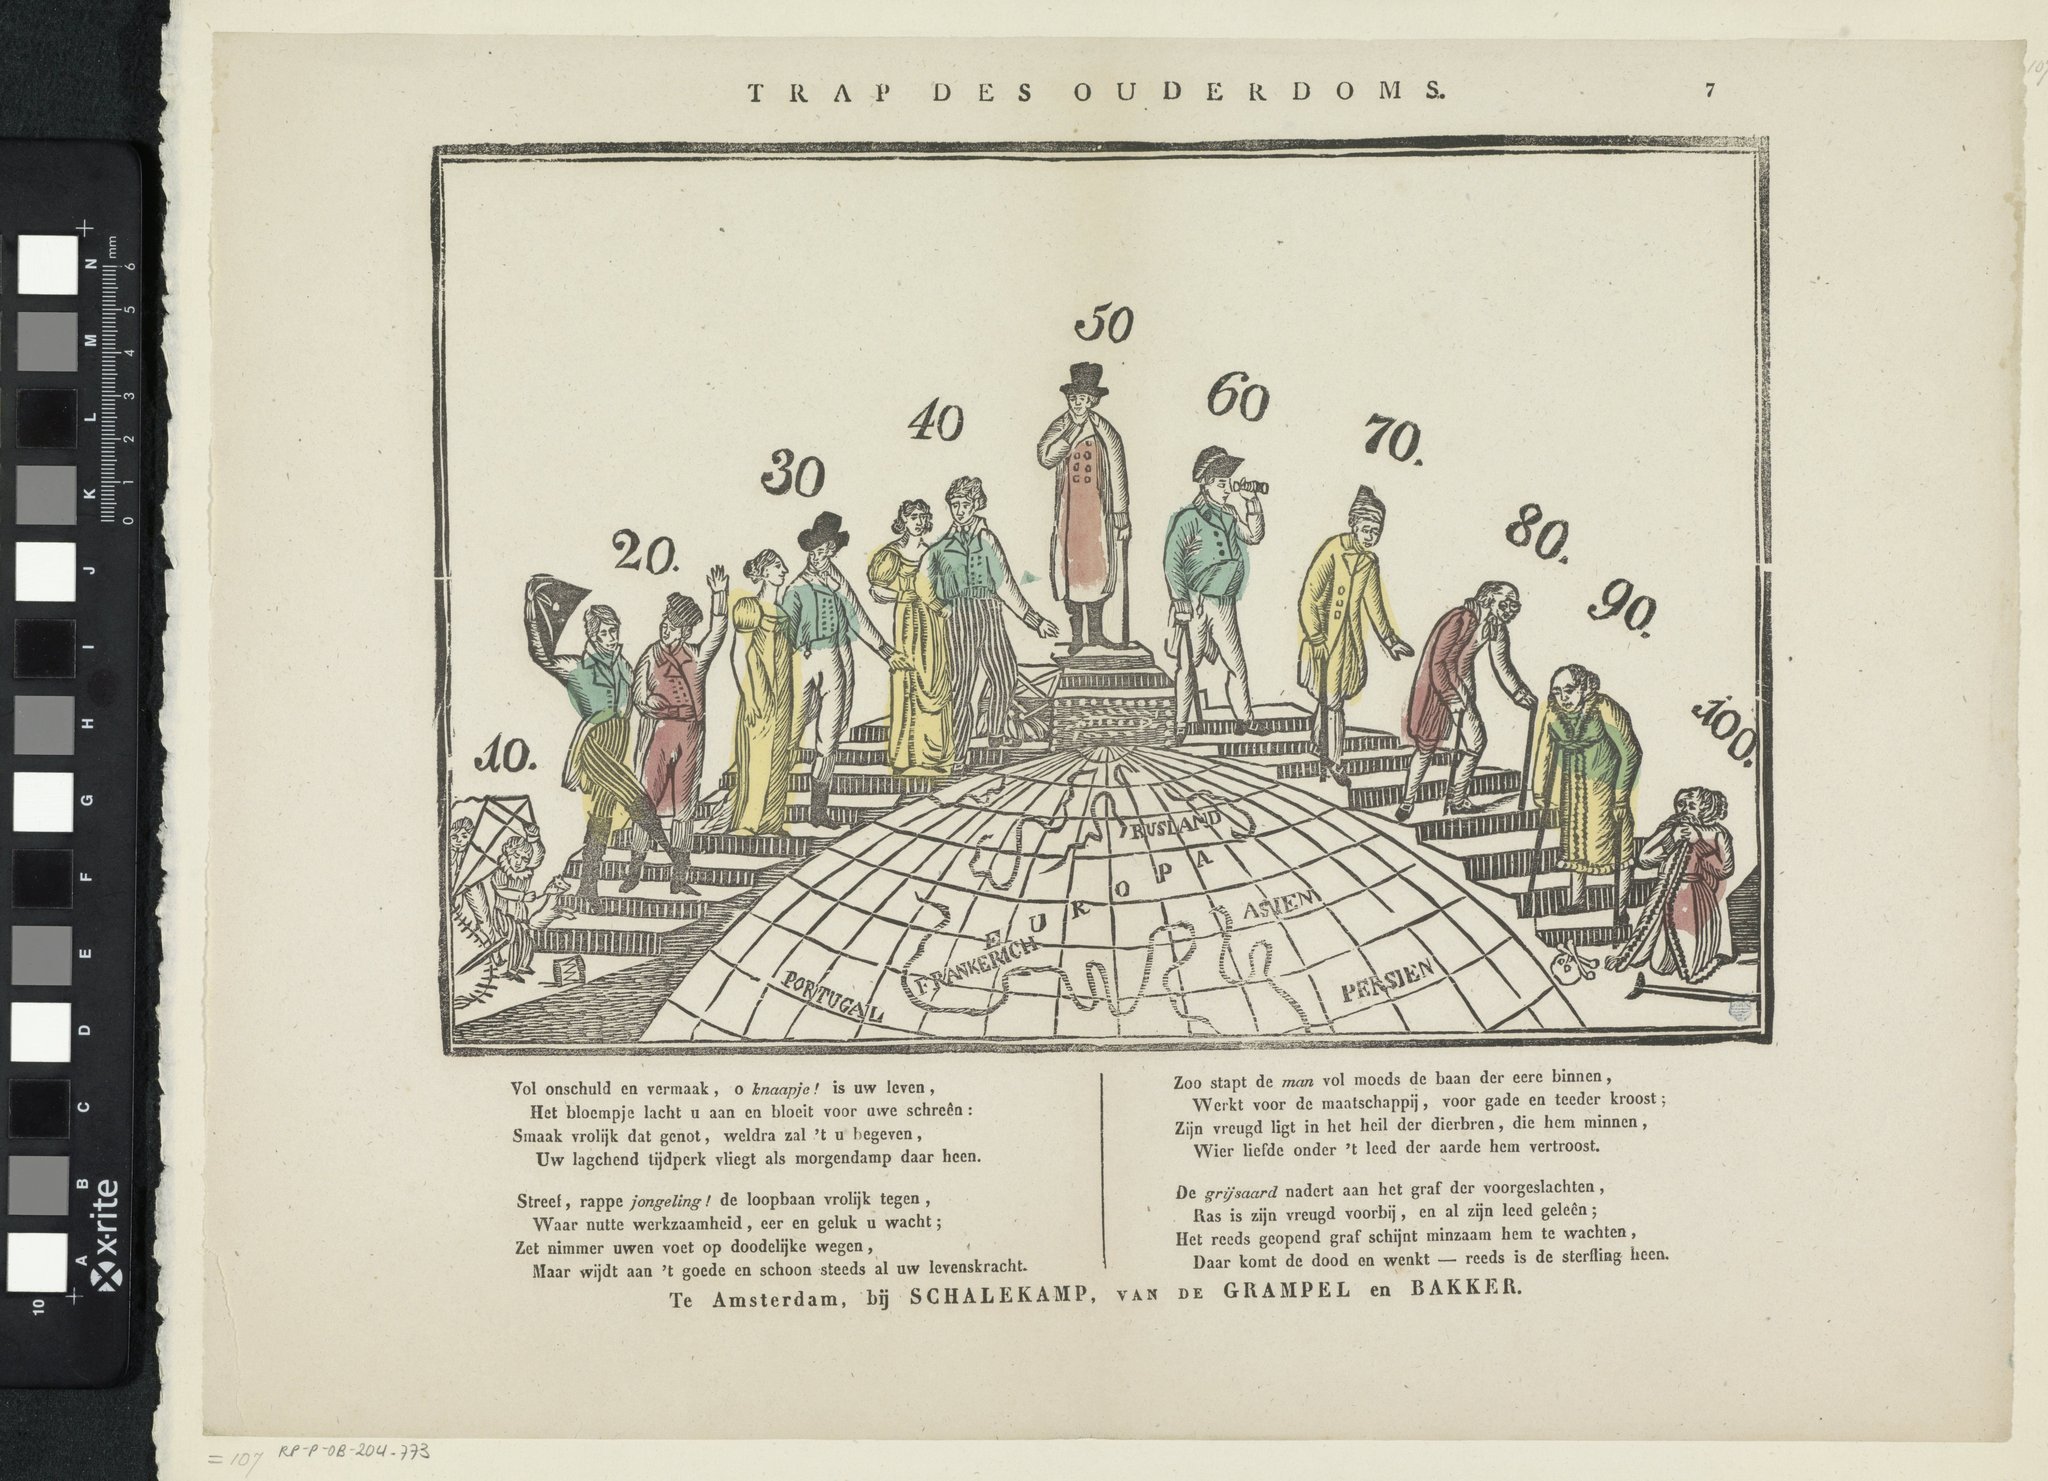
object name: popular print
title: Trap des ouderdoms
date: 1822-1849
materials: paper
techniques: colour, letterpress printing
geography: deventer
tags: the ages of man represented by a staircase, globe, human life divided into stages, russia, france, persia, europe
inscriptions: collector's mark: Lugt 2760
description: Een trap des ouderdoms: een mannentrap. Op de treden van de trap, lopend over de aardbol (het noordelijk halfrond), staan mannen in de leeftijd van 10 tot 100 jaar. Onder de afbeelding een vers in twee kolommen. Genummerd rechtsboven: 7.